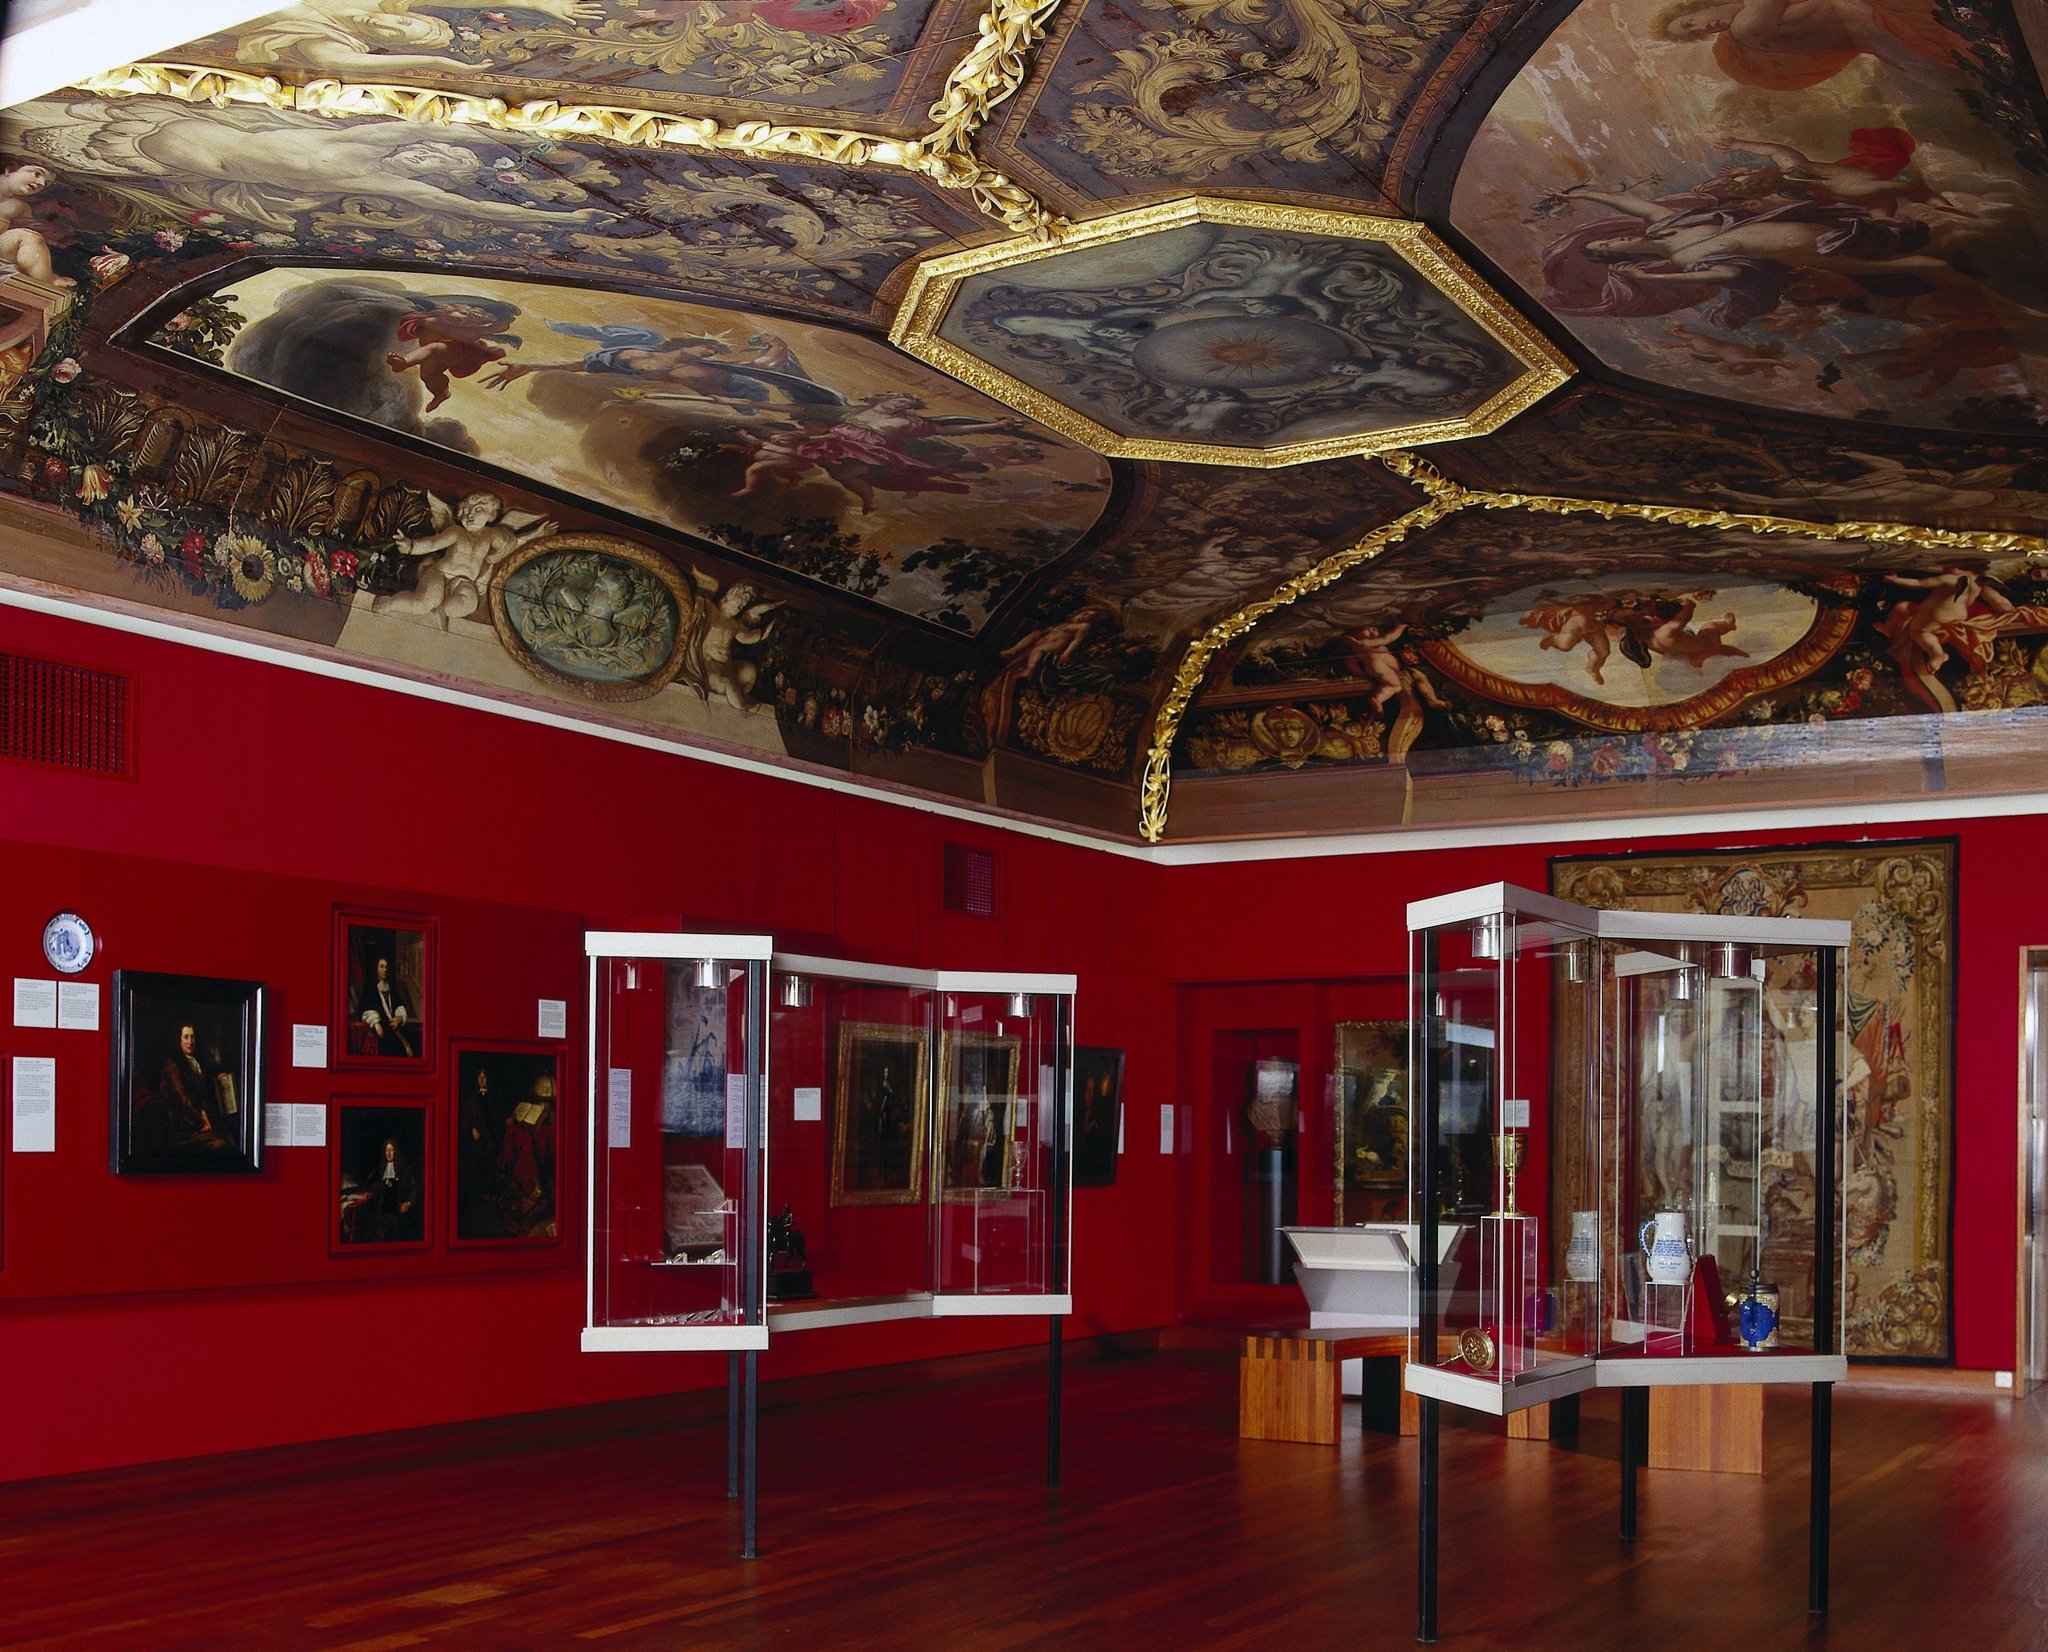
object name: interieuronderdeel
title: Ceiling with representations of Morning and Evening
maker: theodoor van der schuer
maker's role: draughtsman, painter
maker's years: 1634-1707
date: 1666-1695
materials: oil, panel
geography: netherlands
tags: london, maria ii stuart (koningin van engeland, schotland en ierland)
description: Ceiling from the bedroom of Mary Stuart, painted by T. C. van der Schuer, 1678. The wooden ceiling is from the bedchamber of Mary Stuart, wife of Prince William III. The room was at the stadholder's residence in the Binnenhof in The Hague. In 1672 William and Mary had the stadholder's quarters refurbished. Mary would have seen the ceiling as she rose and retired to bed. Which is why it is decorated with mythological scenes reflecting the themes of dawn and night. The two main scenes are on canvas. In the first the goddess Aurora chases the darkness with her torch, flying ahead of the sun god Apollo. On the other side of the ceiling night approaches and Apollo is chased away by a female figure.